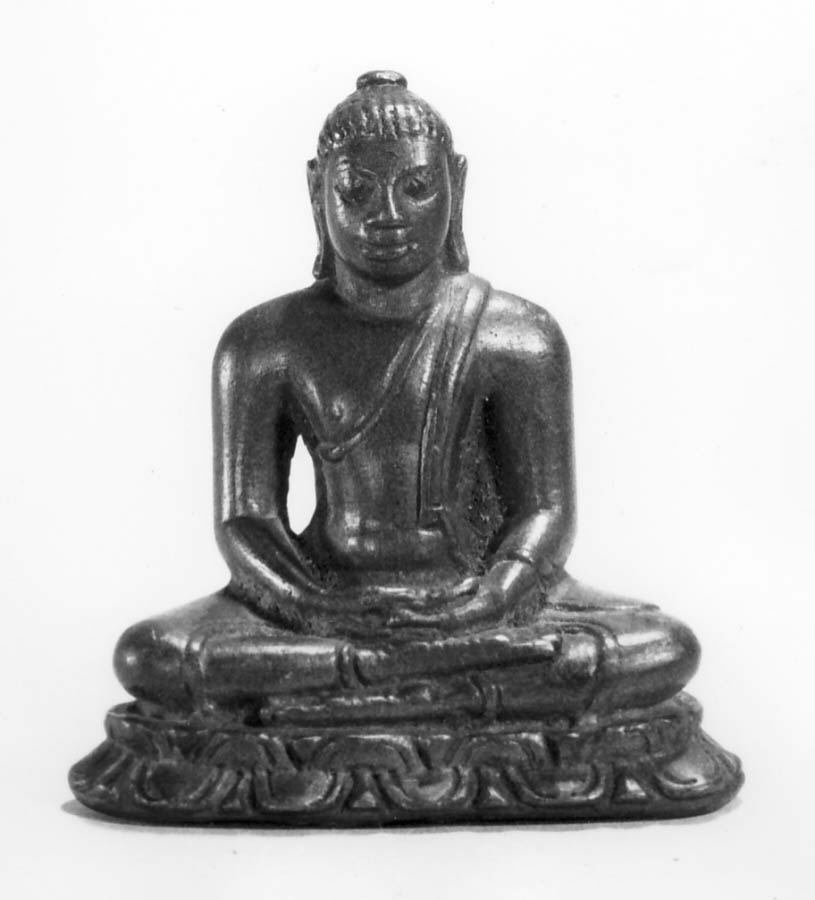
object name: figurine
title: Seated Buddha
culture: sri lankan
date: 1101-1200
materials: bronze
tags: buddhism,buddha